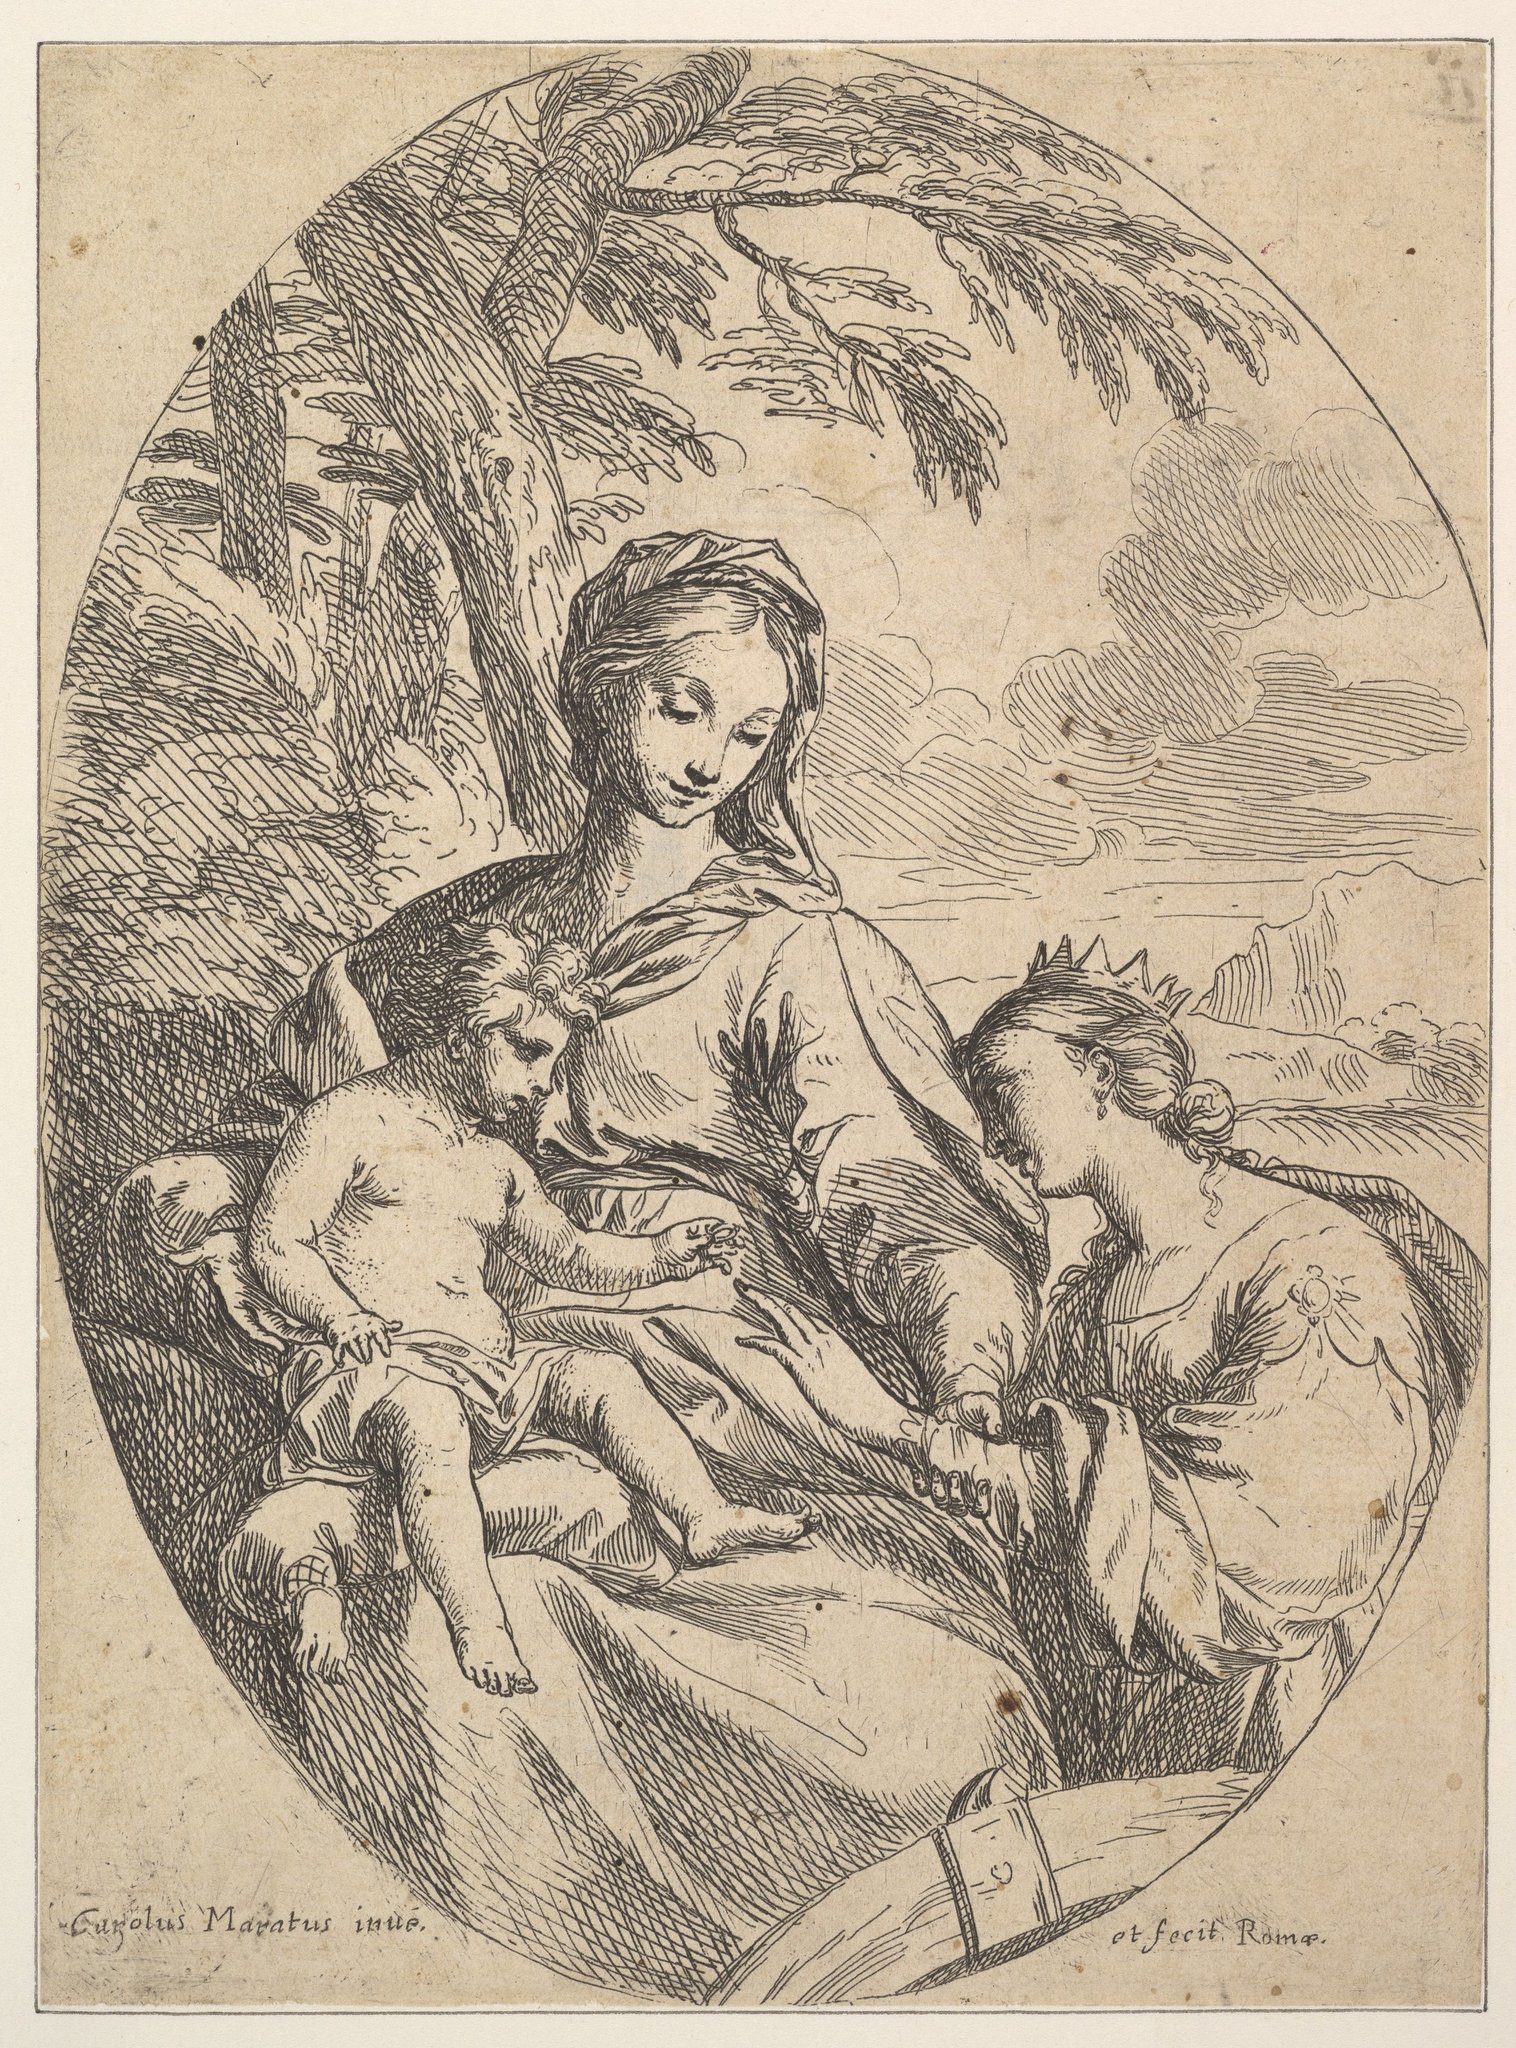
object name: print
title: The Marriage of St. Catherine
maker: carlo maratti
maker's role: artist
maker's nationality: italian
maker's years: 1625-1713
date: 1625-1713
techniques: etching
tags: madonna and child,saint catherine